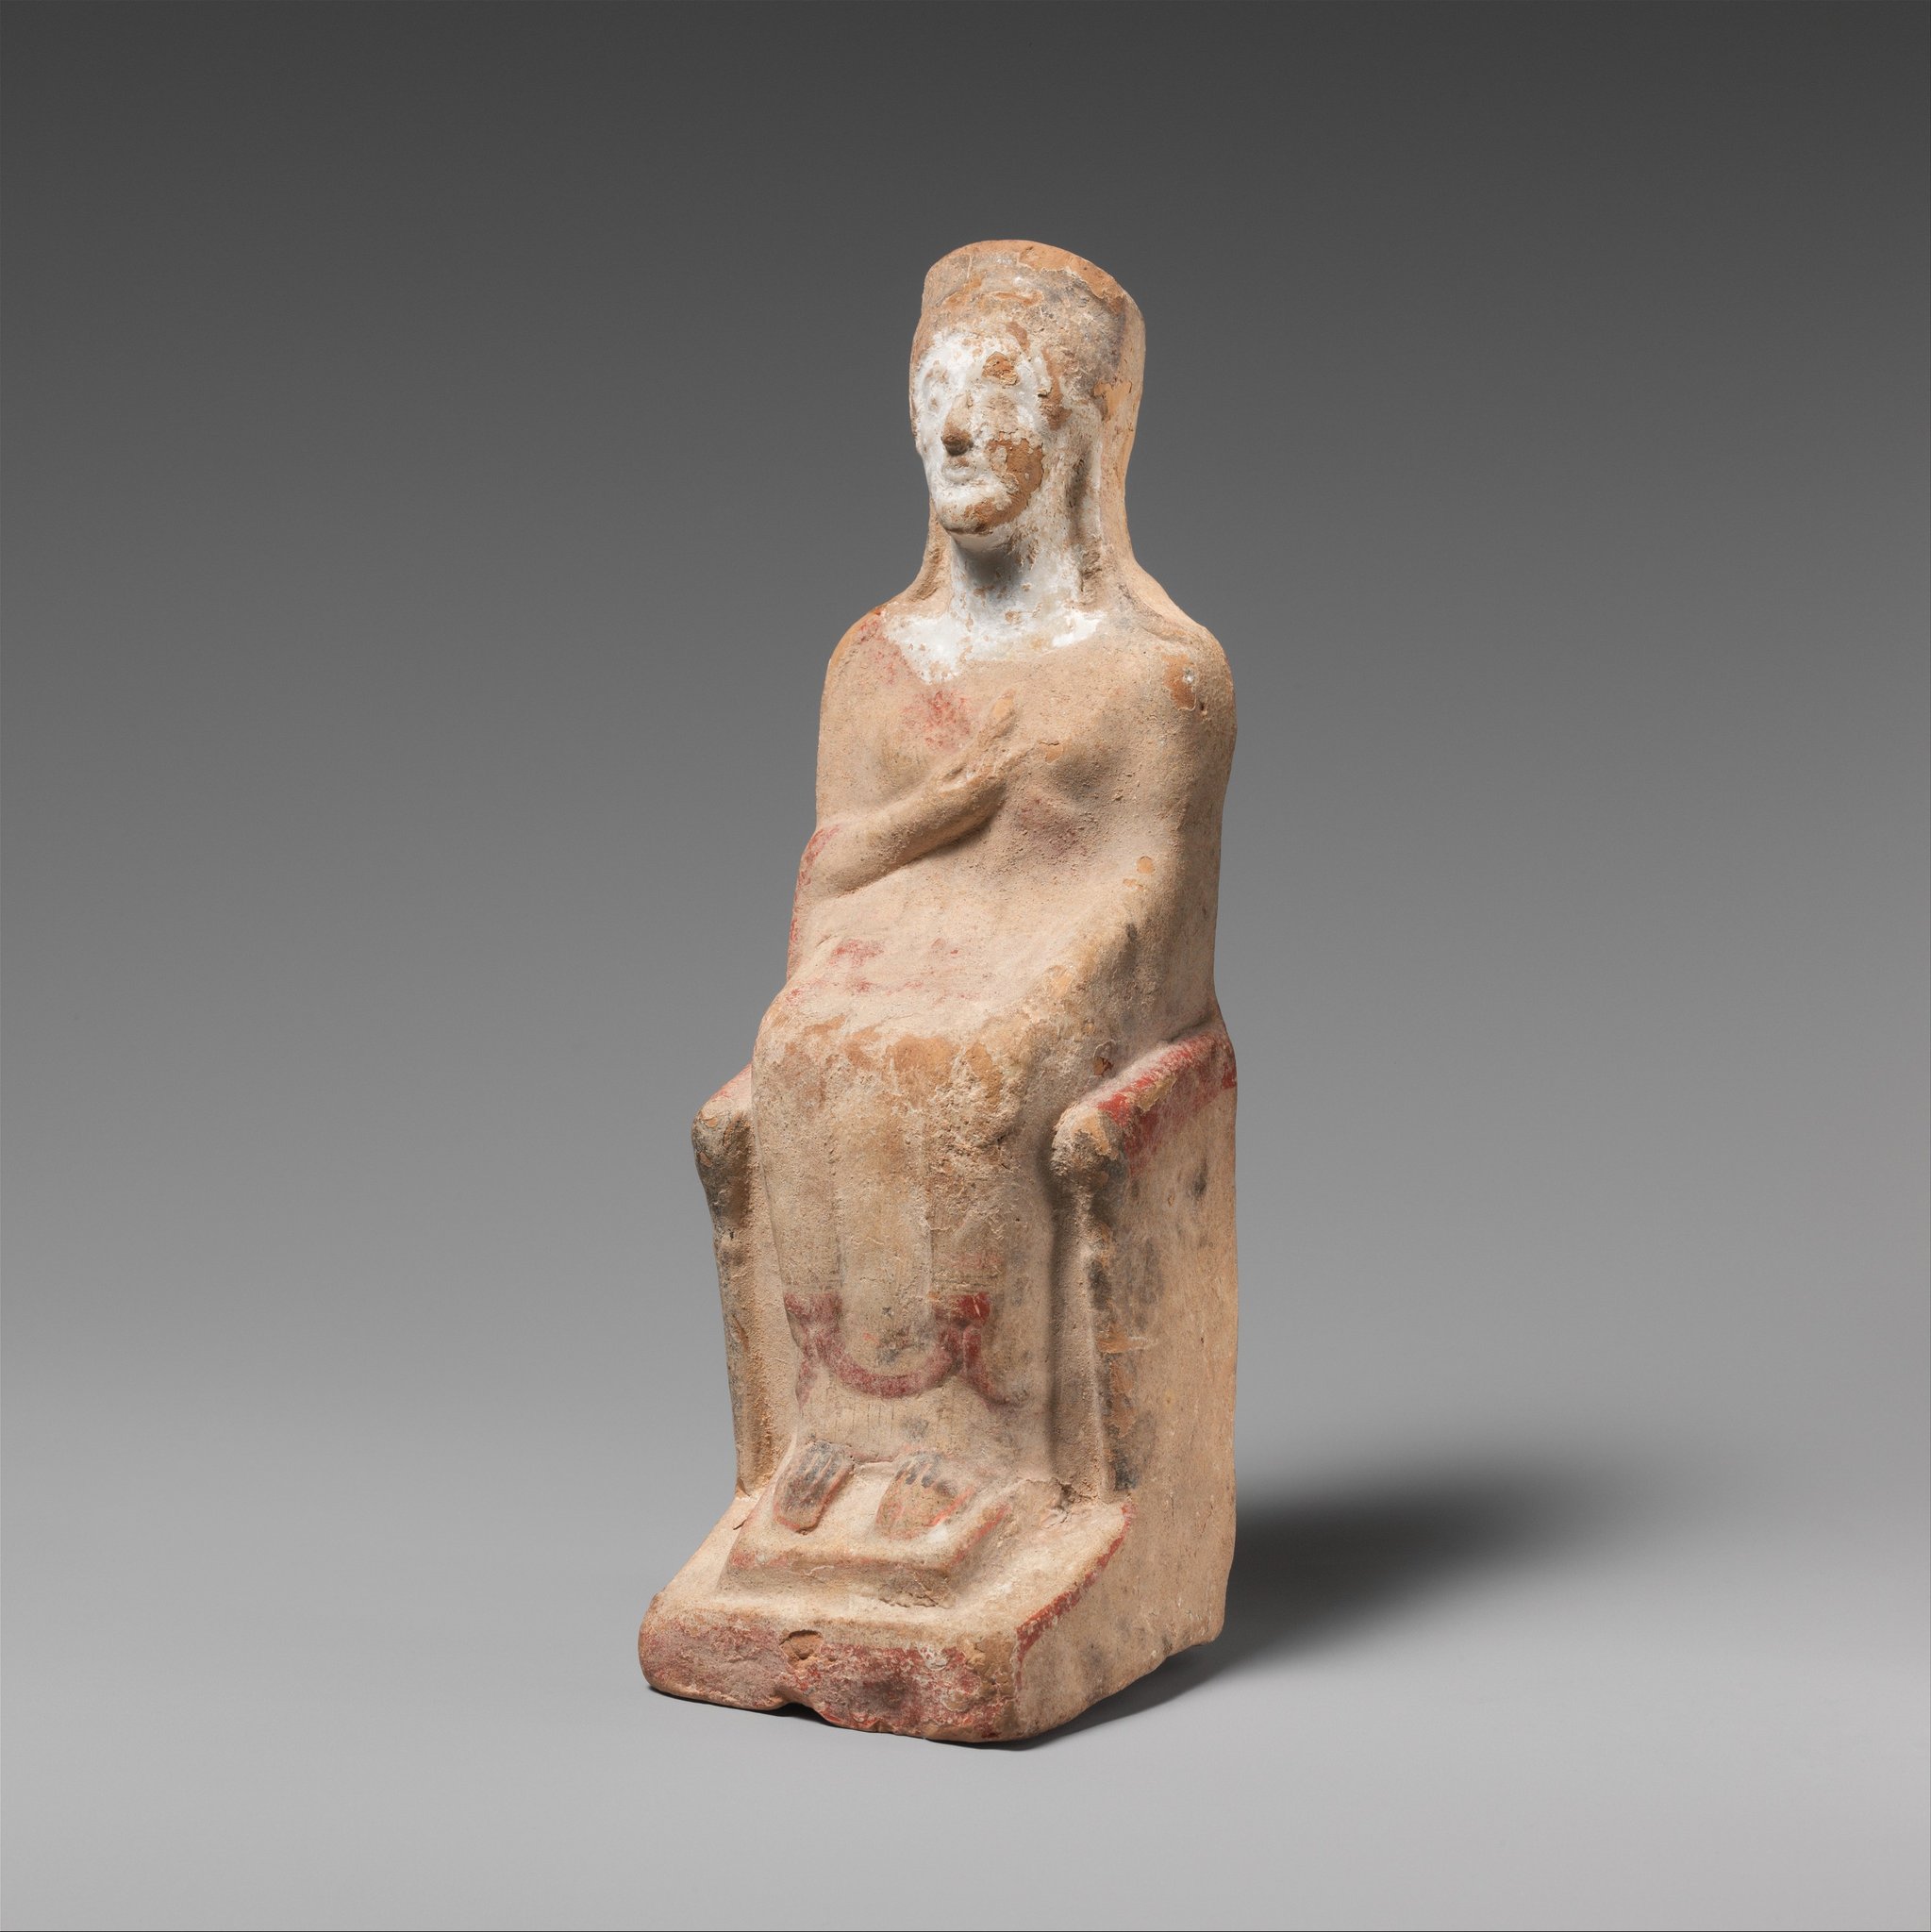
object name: statuette of a woman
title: Terracotta statuette of a seated woman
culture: greek, attic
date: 500-468 BCE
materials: terracotta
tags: women